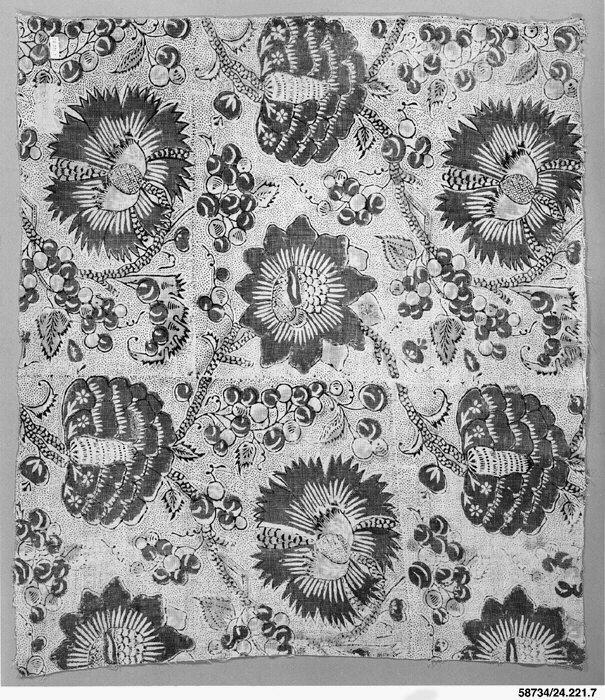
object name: piece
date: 1775-1785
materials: linen